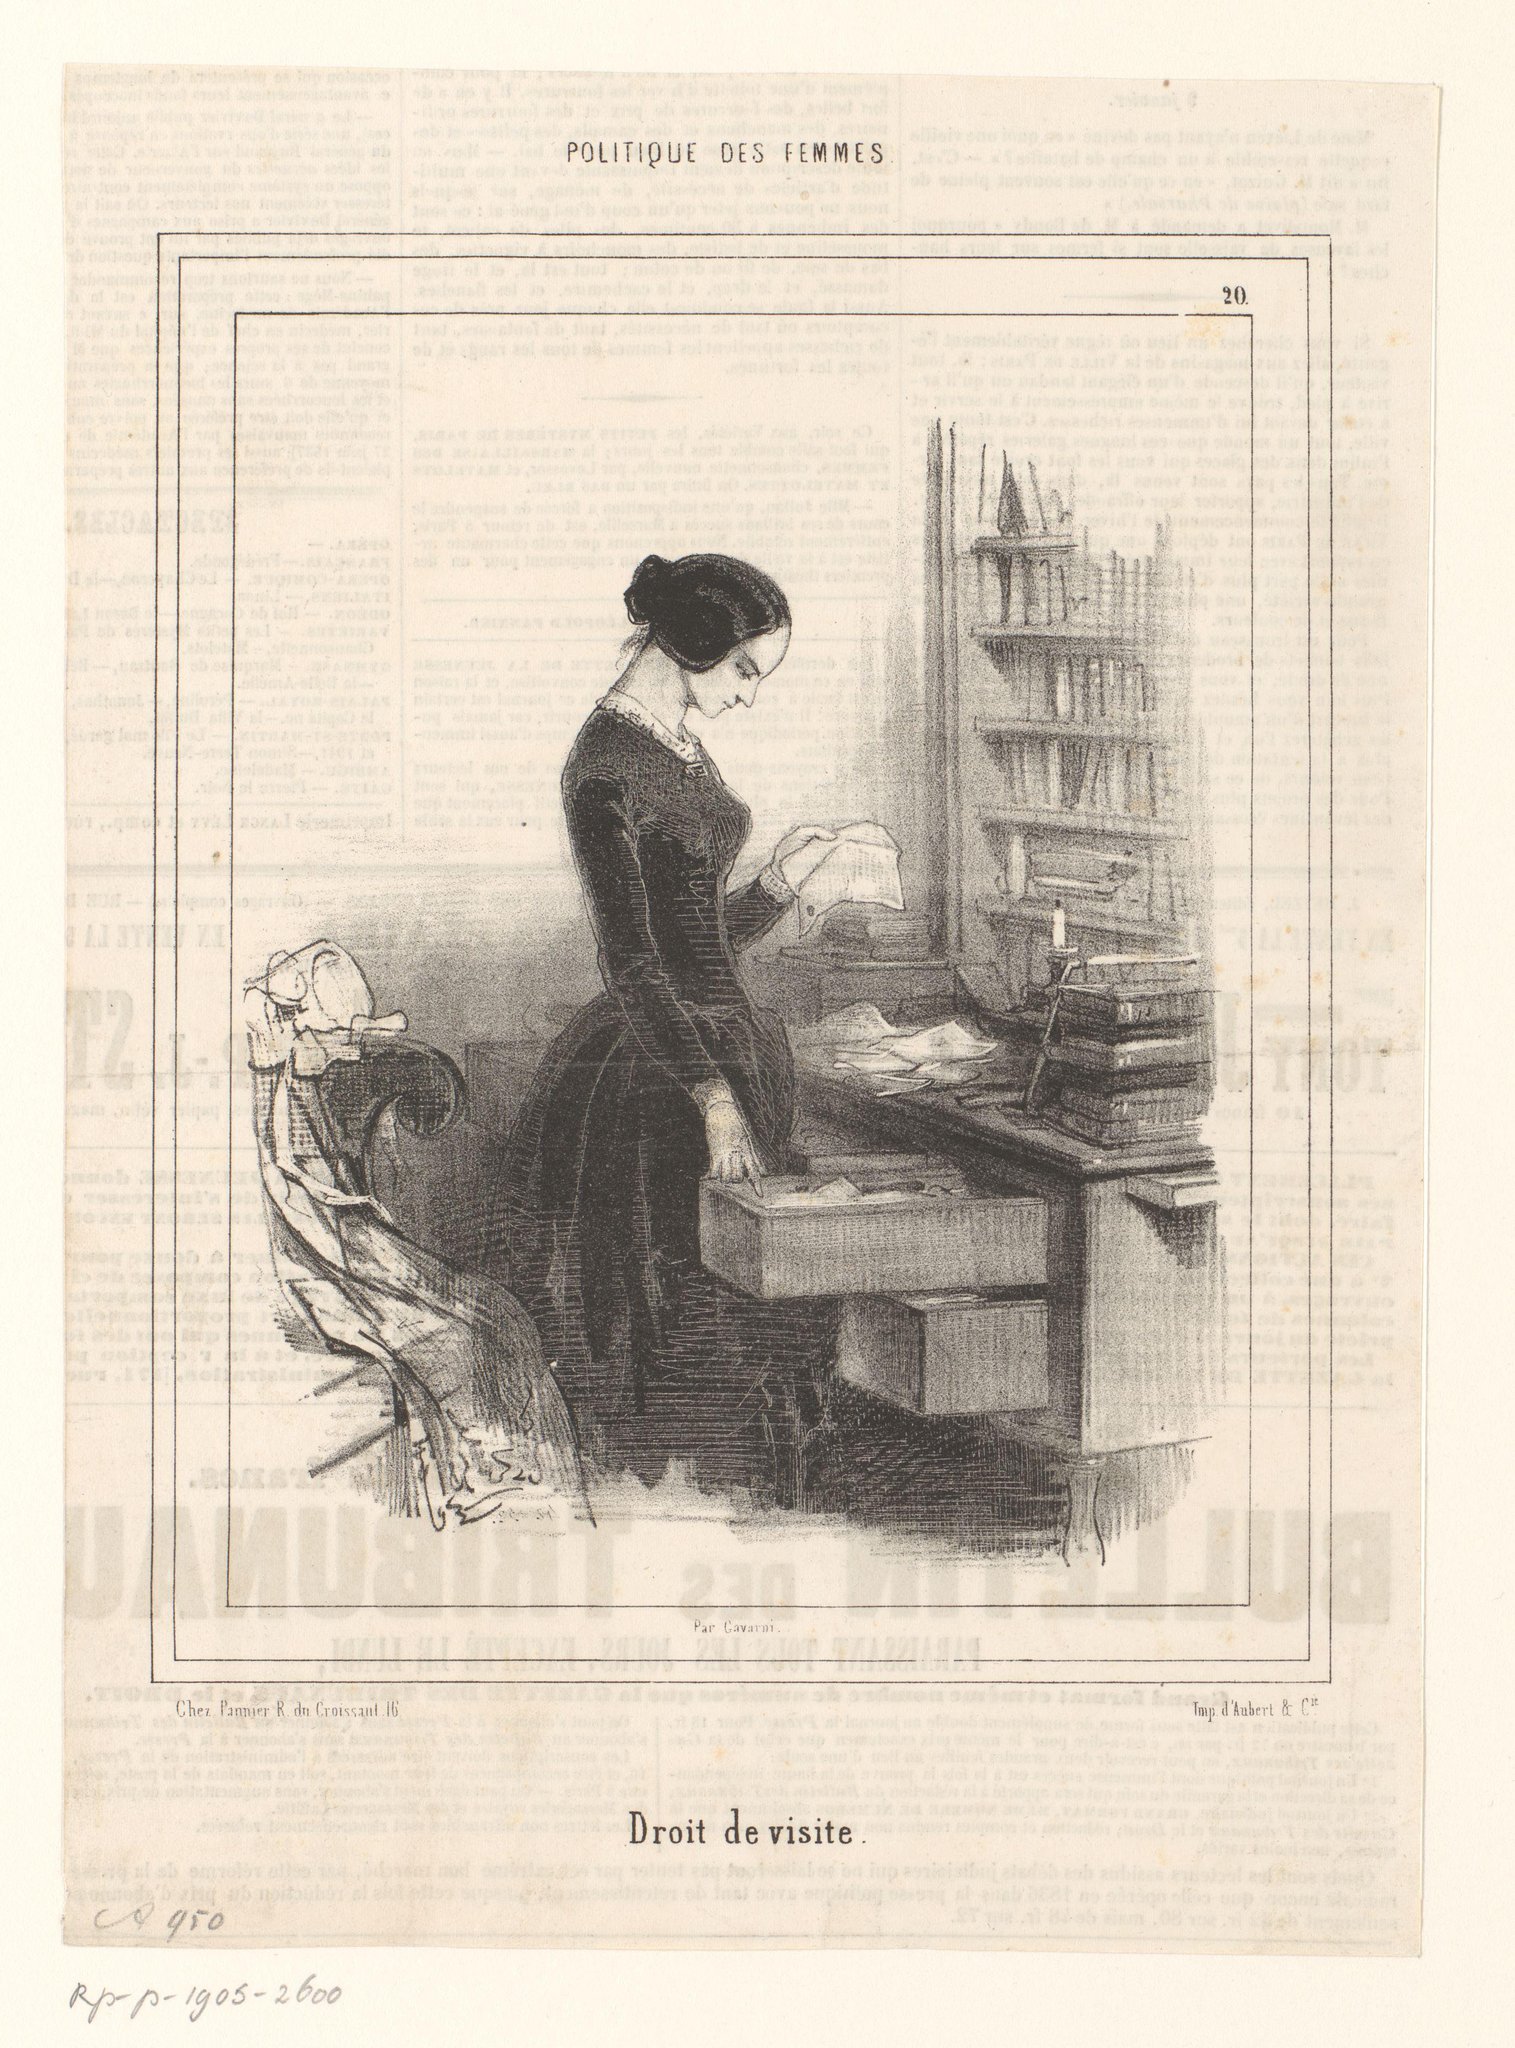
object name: cartoon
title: Droit de visite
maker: paul gavarni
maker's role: draughtsman, print maker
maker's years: 1804-1866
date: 1843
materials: paper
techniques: lithograph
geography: paris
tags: writing-table, writing-desk, adult woman, reading, letter, envelope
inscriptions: collector's mark: Lugt 2228a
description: Prent gebruikt voor: Le Charivari, 10 januari 1843.